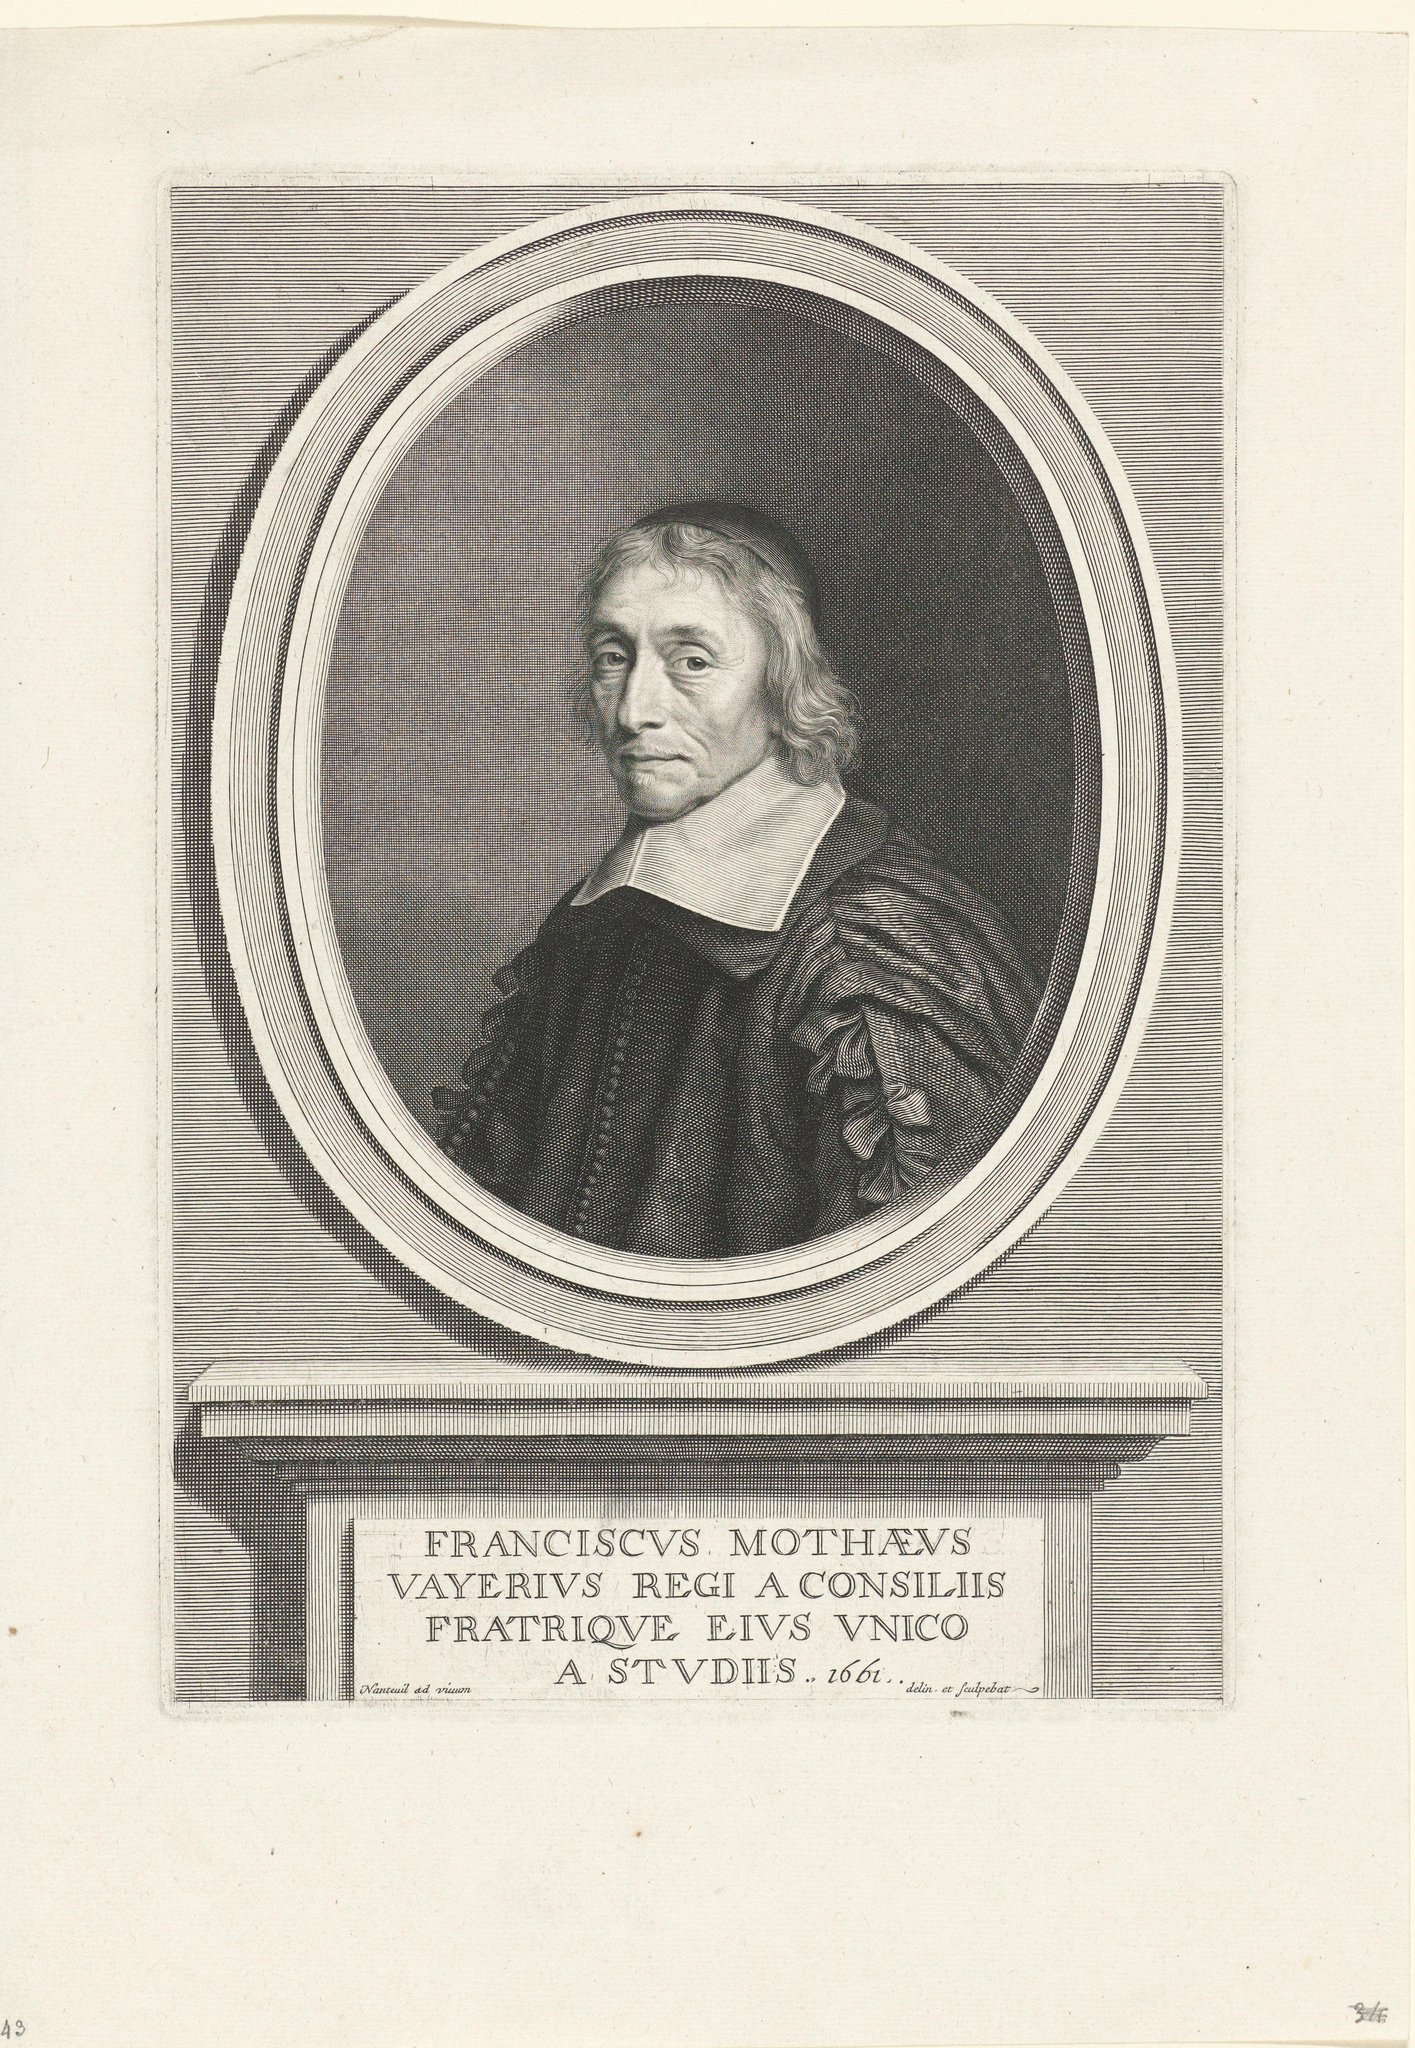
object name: print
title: Portret van François de la Mothe le Vayer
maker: robert nanteuil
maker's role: print maker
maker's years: 1623-1678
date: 1661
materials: paper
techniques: engraving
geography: france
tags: paris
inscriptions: collector's mark: Lugt 240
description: Portret van de staatsman François de la Mothe le Vayer driekwart naar links, in een ovaal staand op een piëdestal. Daarop een cartouche met tekst.